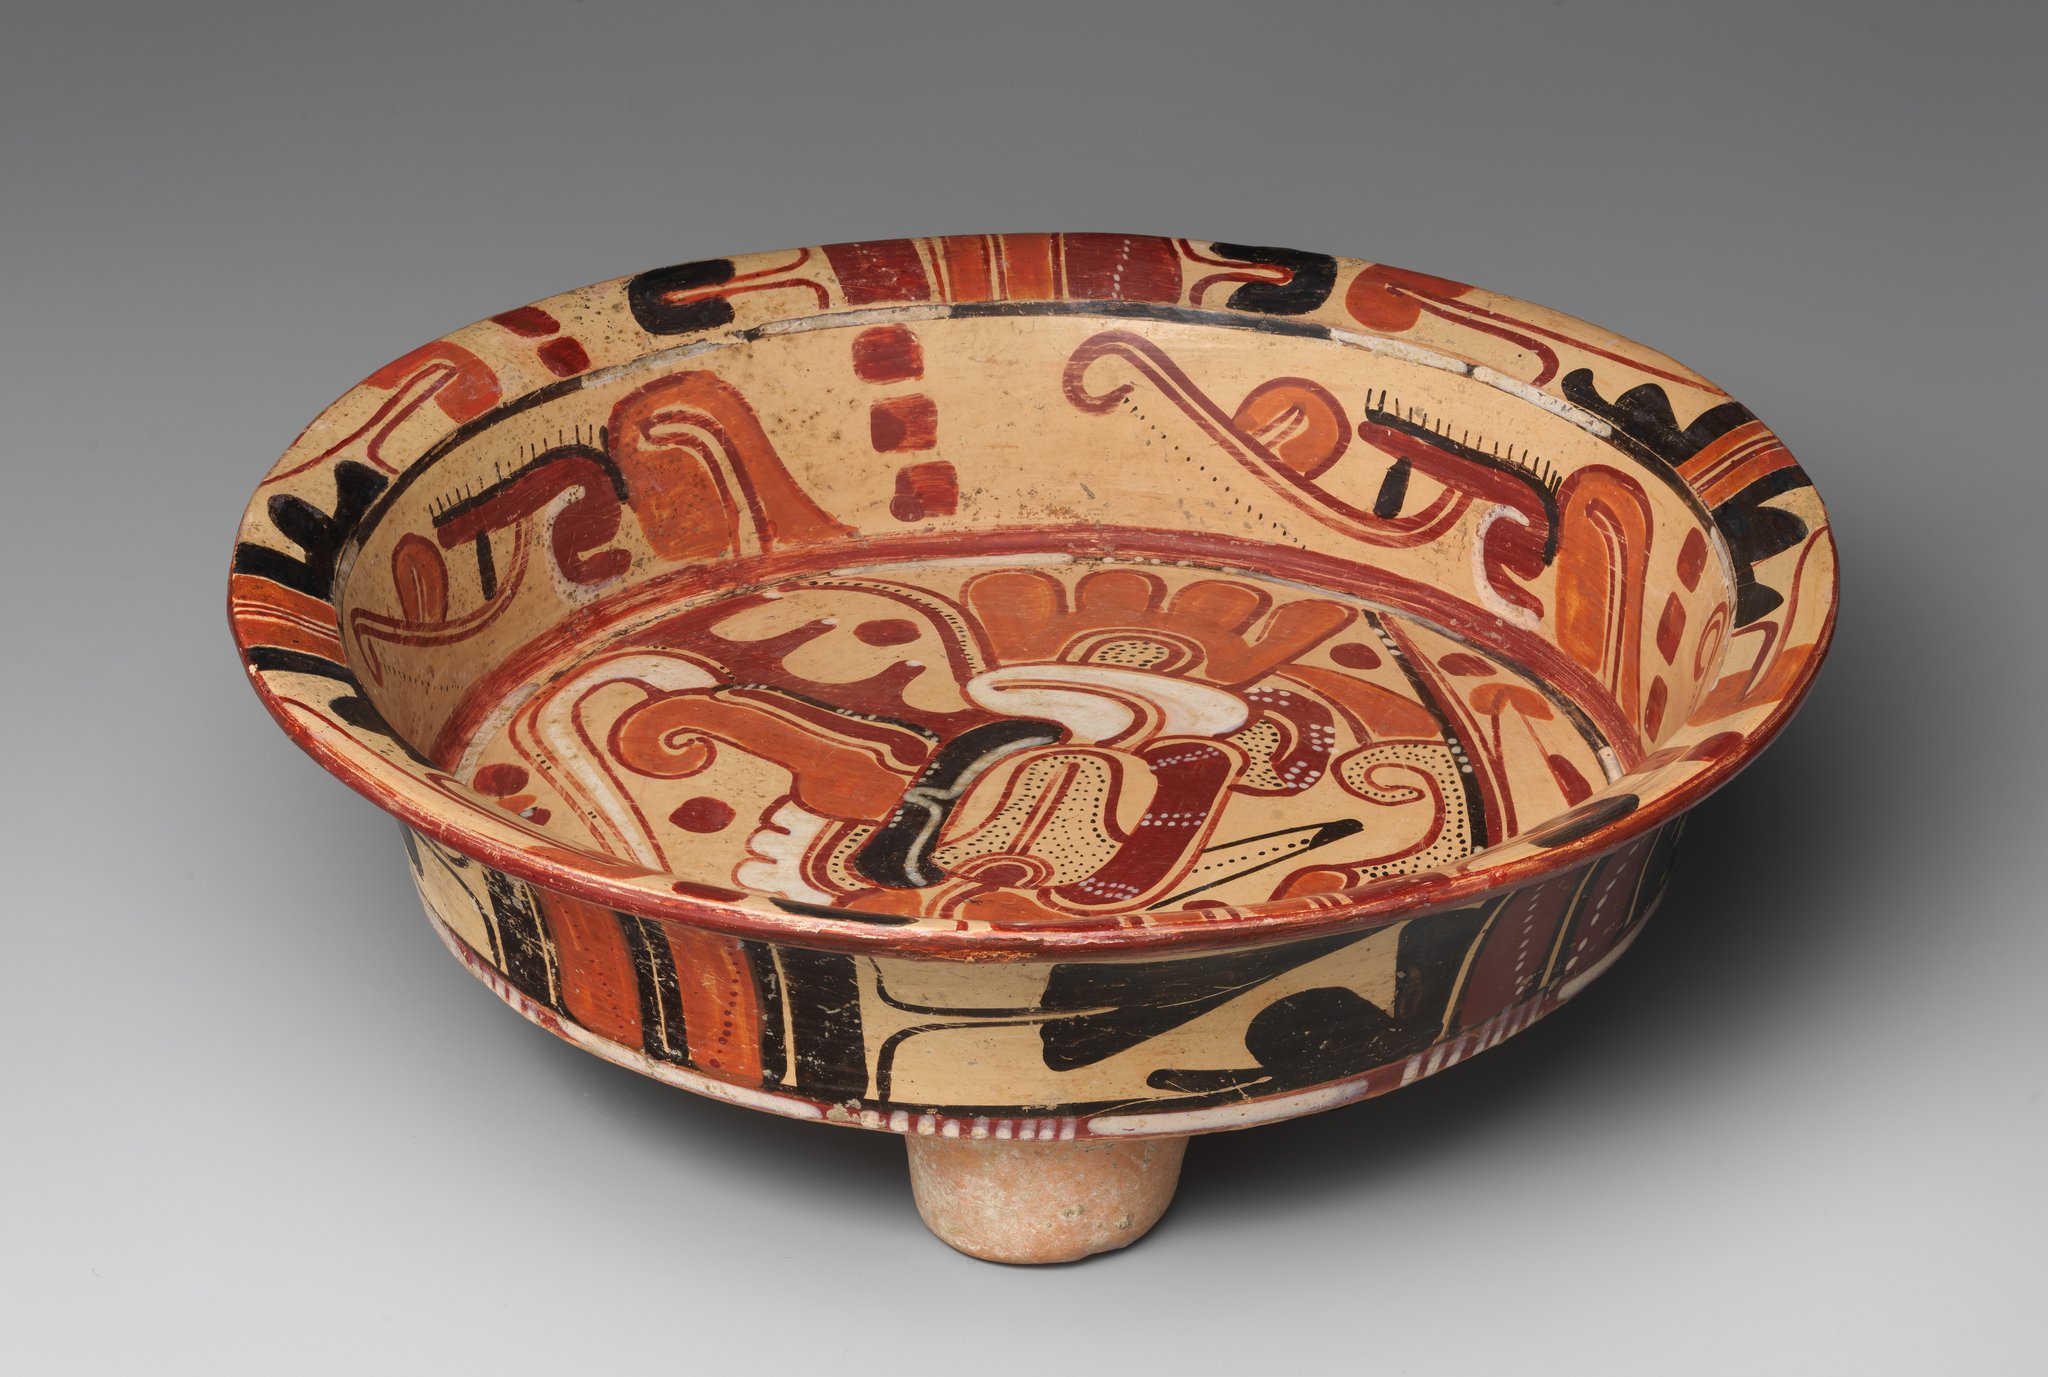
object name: bowl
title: Tripod bowl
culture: classic veracruz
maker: los tuxtlas artist(s)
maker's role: artist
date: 600-1100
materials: ceramic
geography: mexico